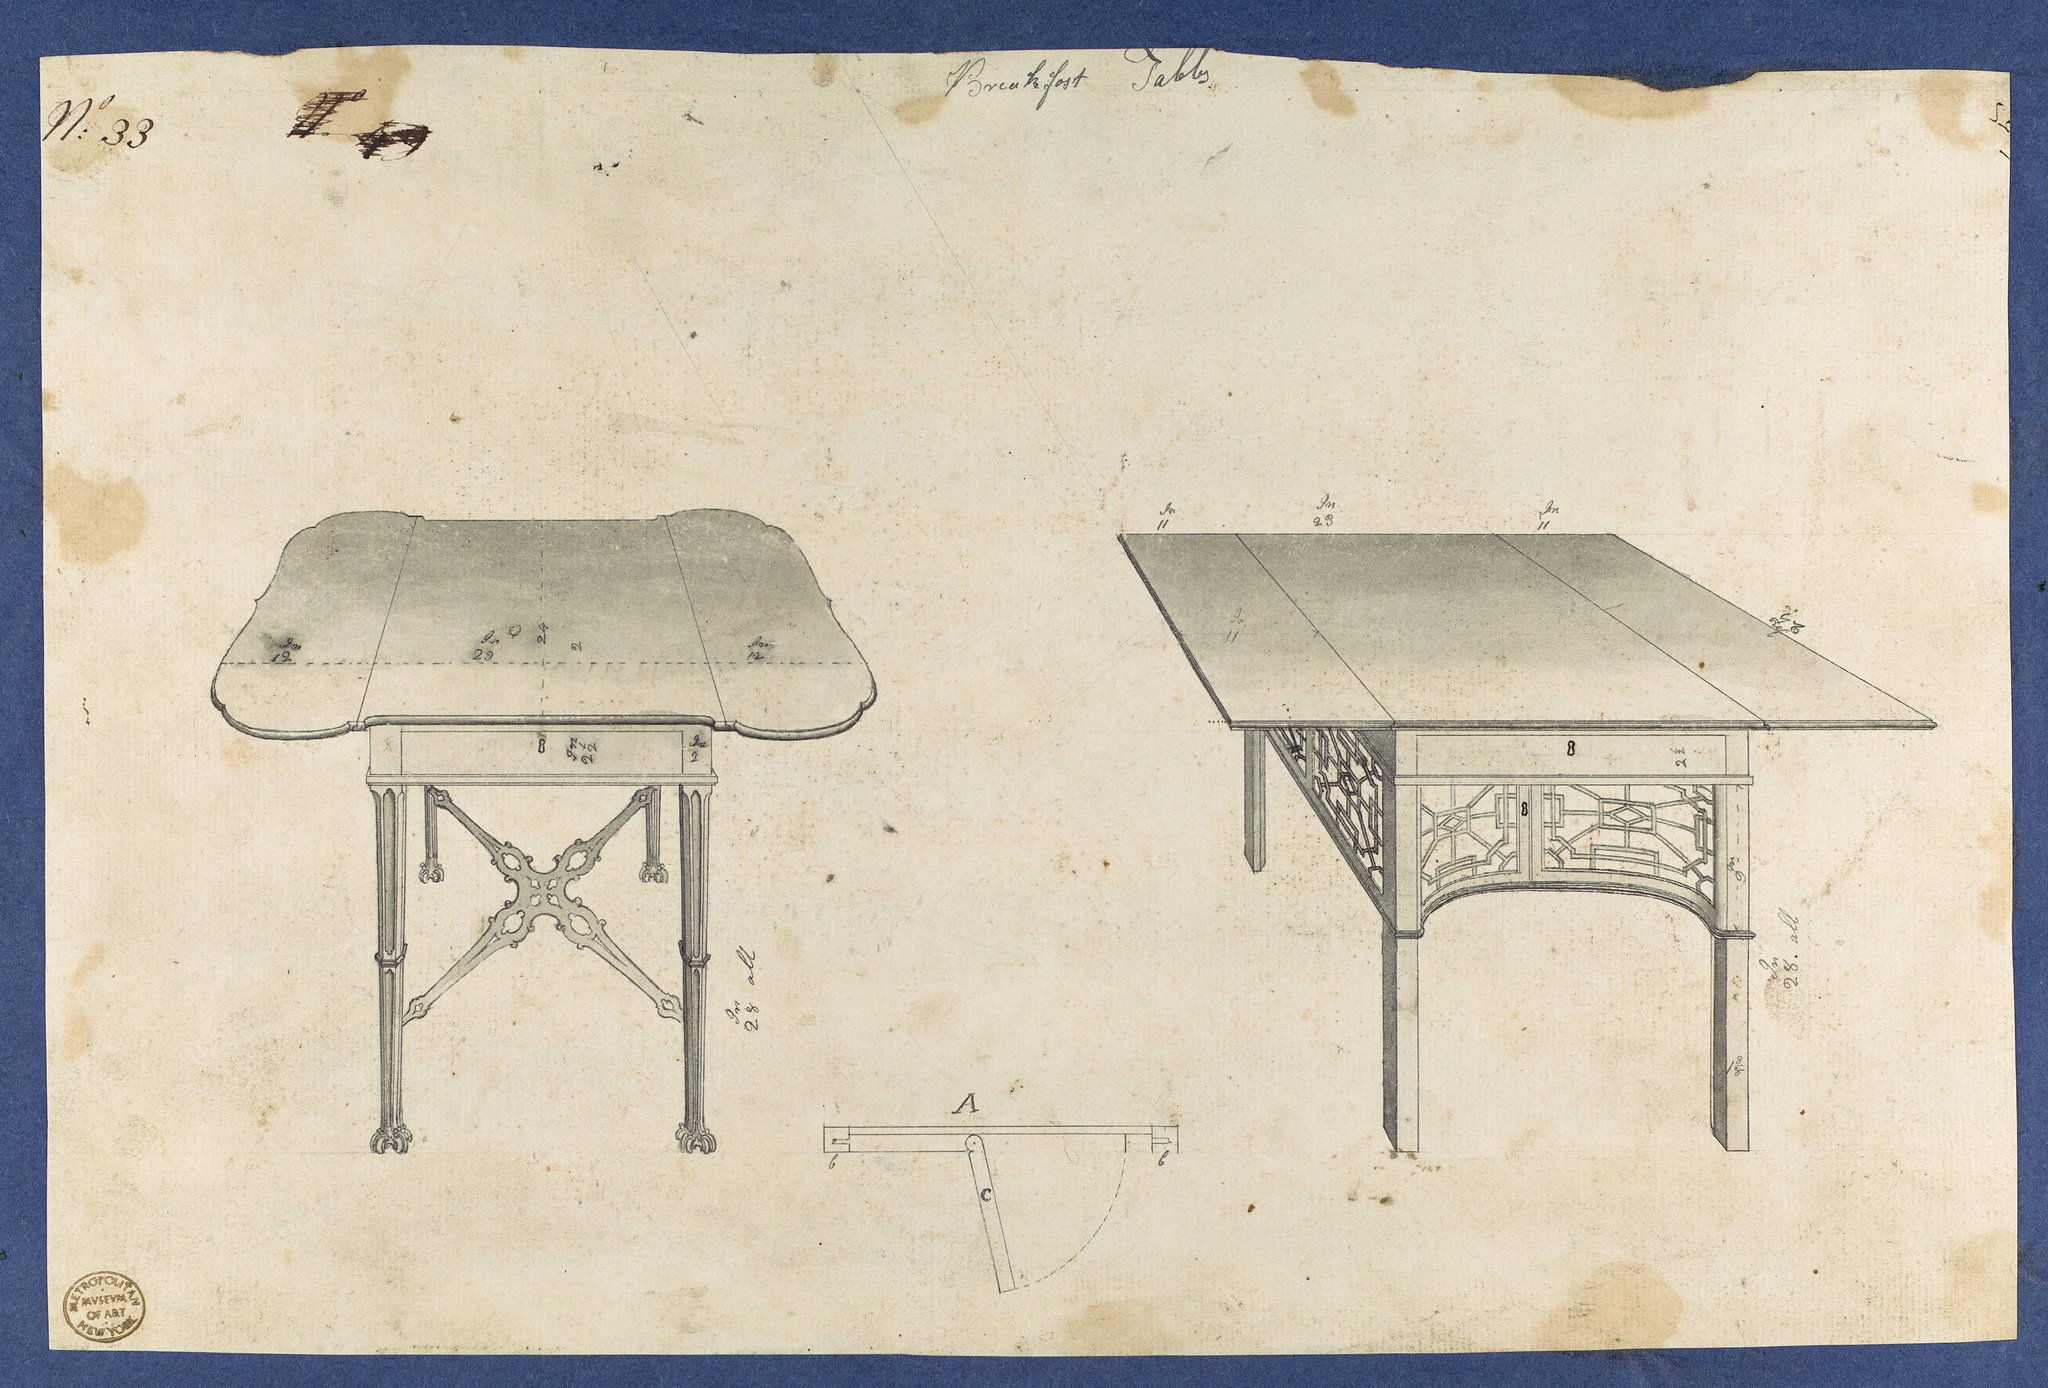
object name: drawing ornament architecture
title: Breakfast Tables, from Chippendale Drawings, Vol. II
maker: thomas chippendale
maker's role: artist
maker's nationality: british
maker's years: 1718-1779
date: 1754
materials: ink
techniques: wash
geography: london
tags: tables